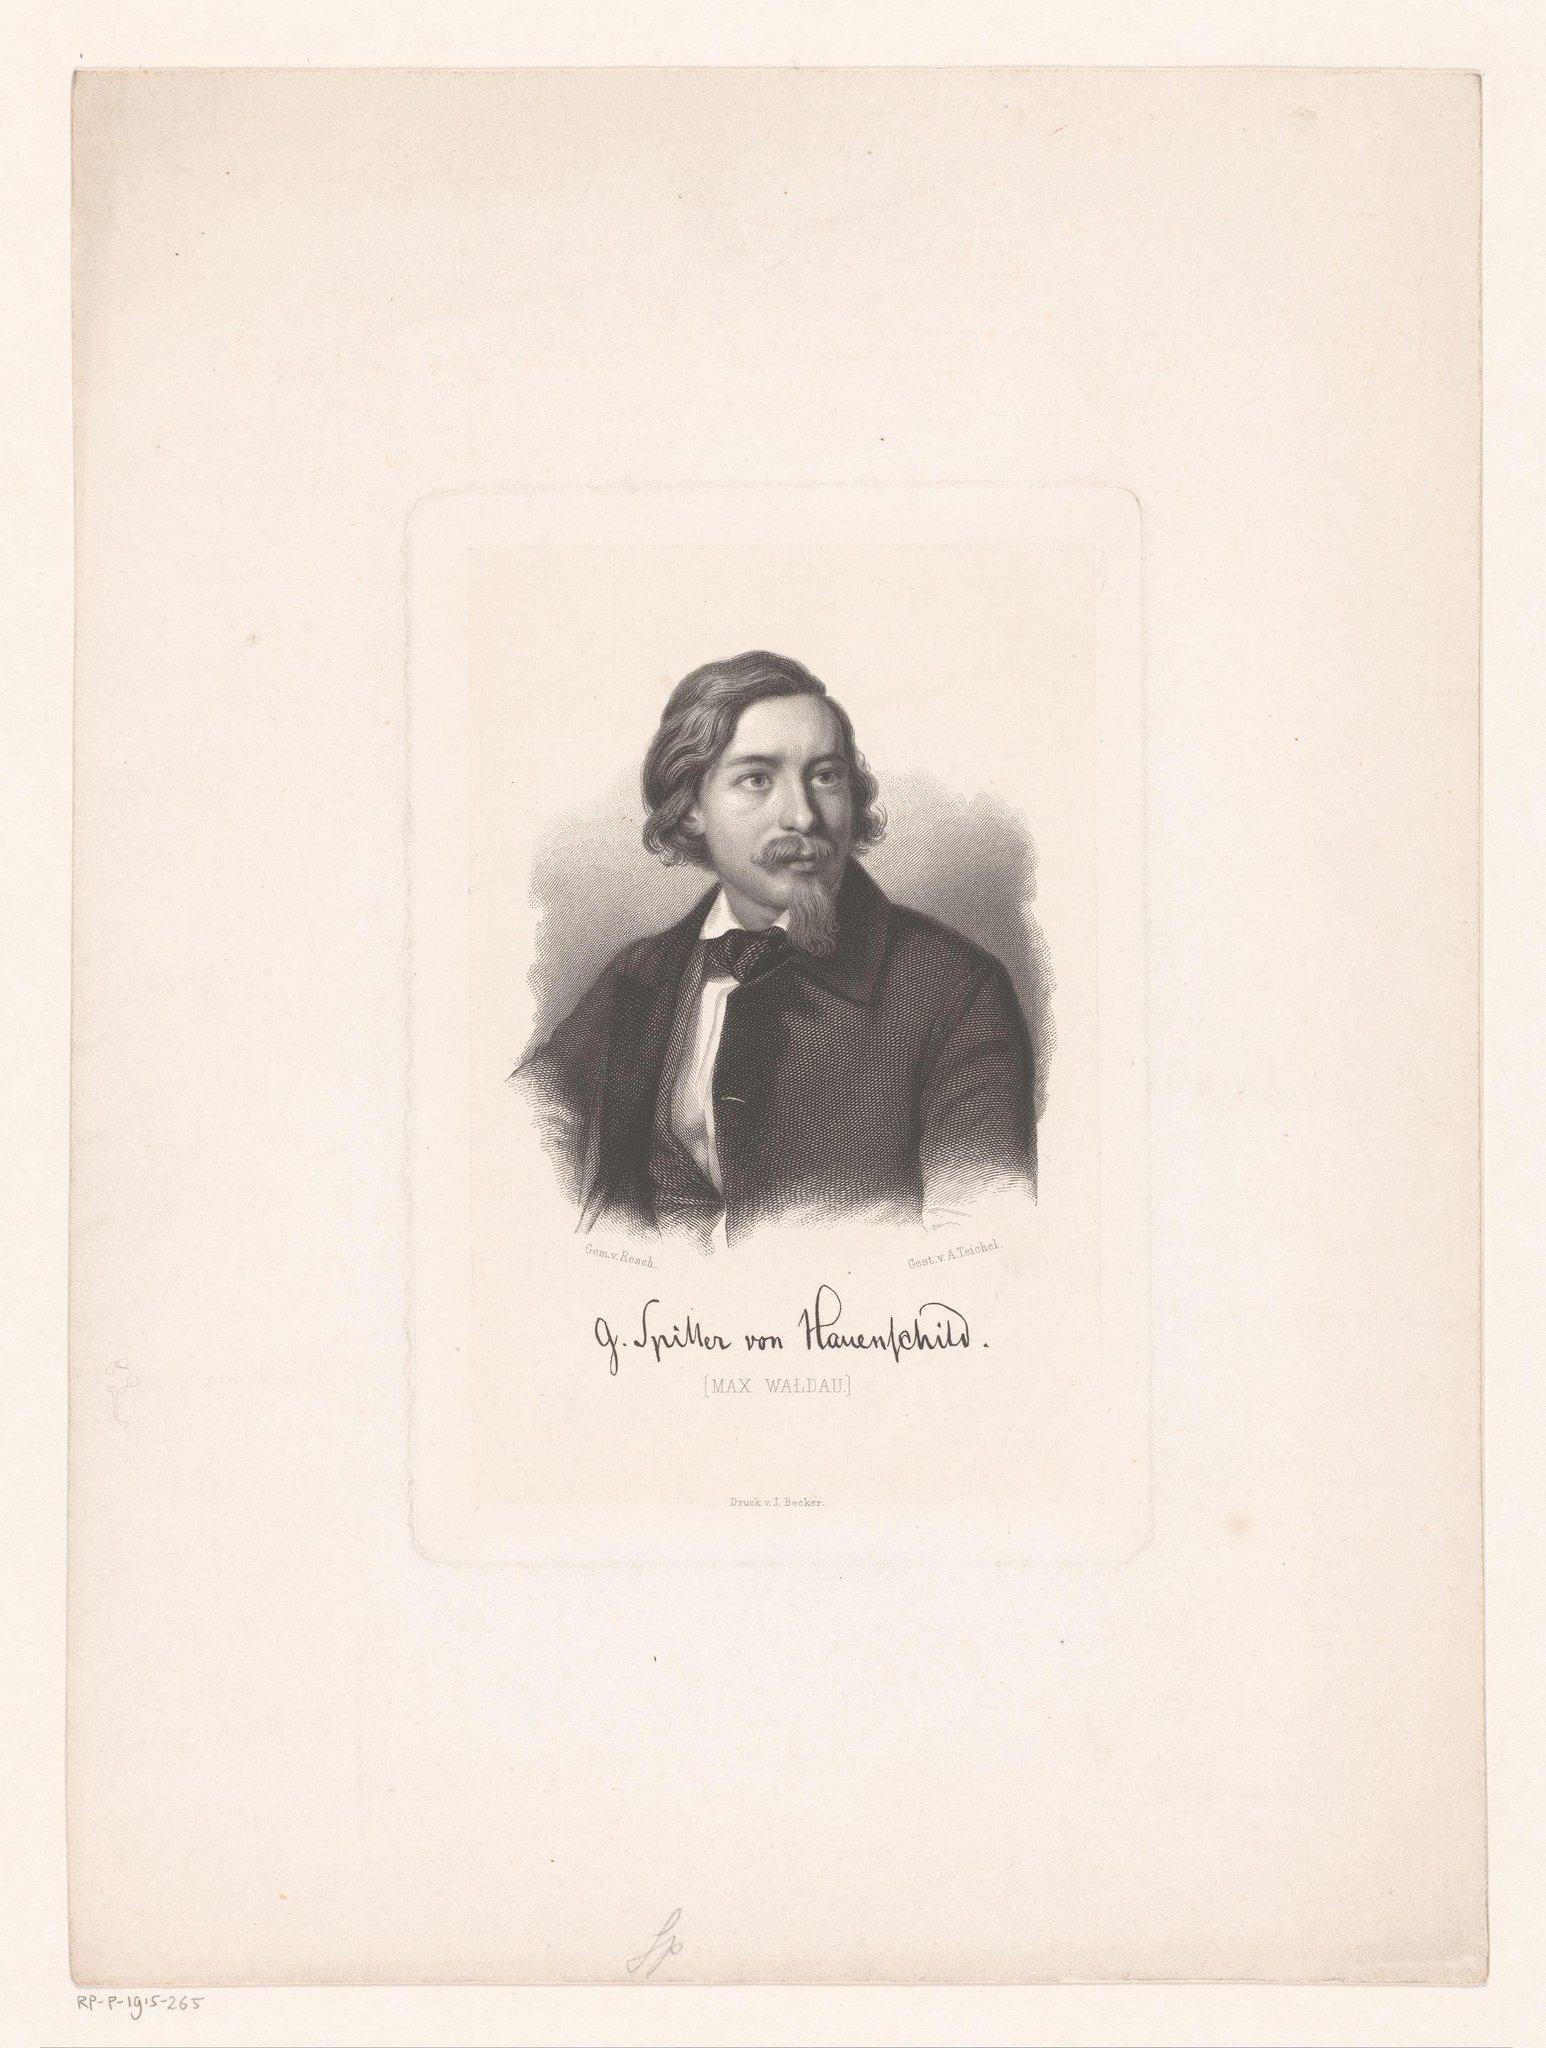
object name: print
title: Portret van Max Waldau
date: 1850-1873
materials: paper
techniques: engraving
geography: germany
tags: poland, historical persons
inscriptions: collector's mark: Lugt 2228